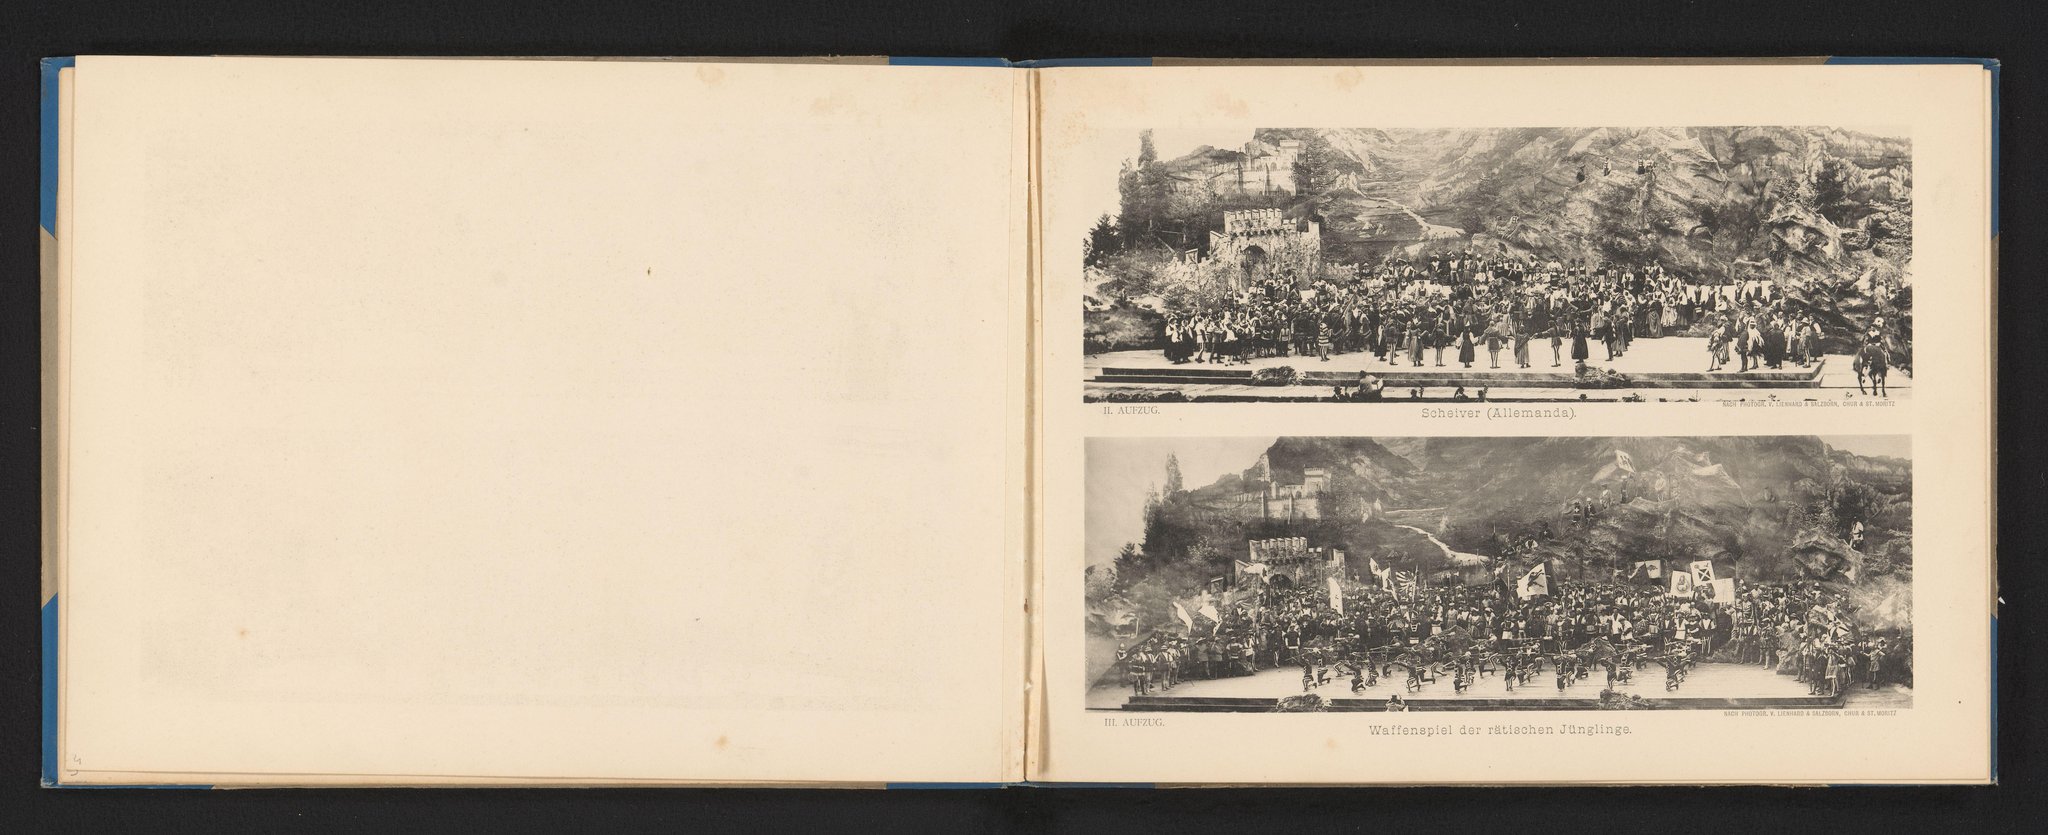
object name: page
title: Gezicht op twee opvoeringen tijdens de Calven-Feier te Chur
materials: paper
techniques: photograph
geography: chur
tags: activities in the air ~ public festivities, e.g. fly-past, musical drama, performance of musical drama, swearing an oath (with two fingers raised)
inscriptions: number: ‘II. III.’